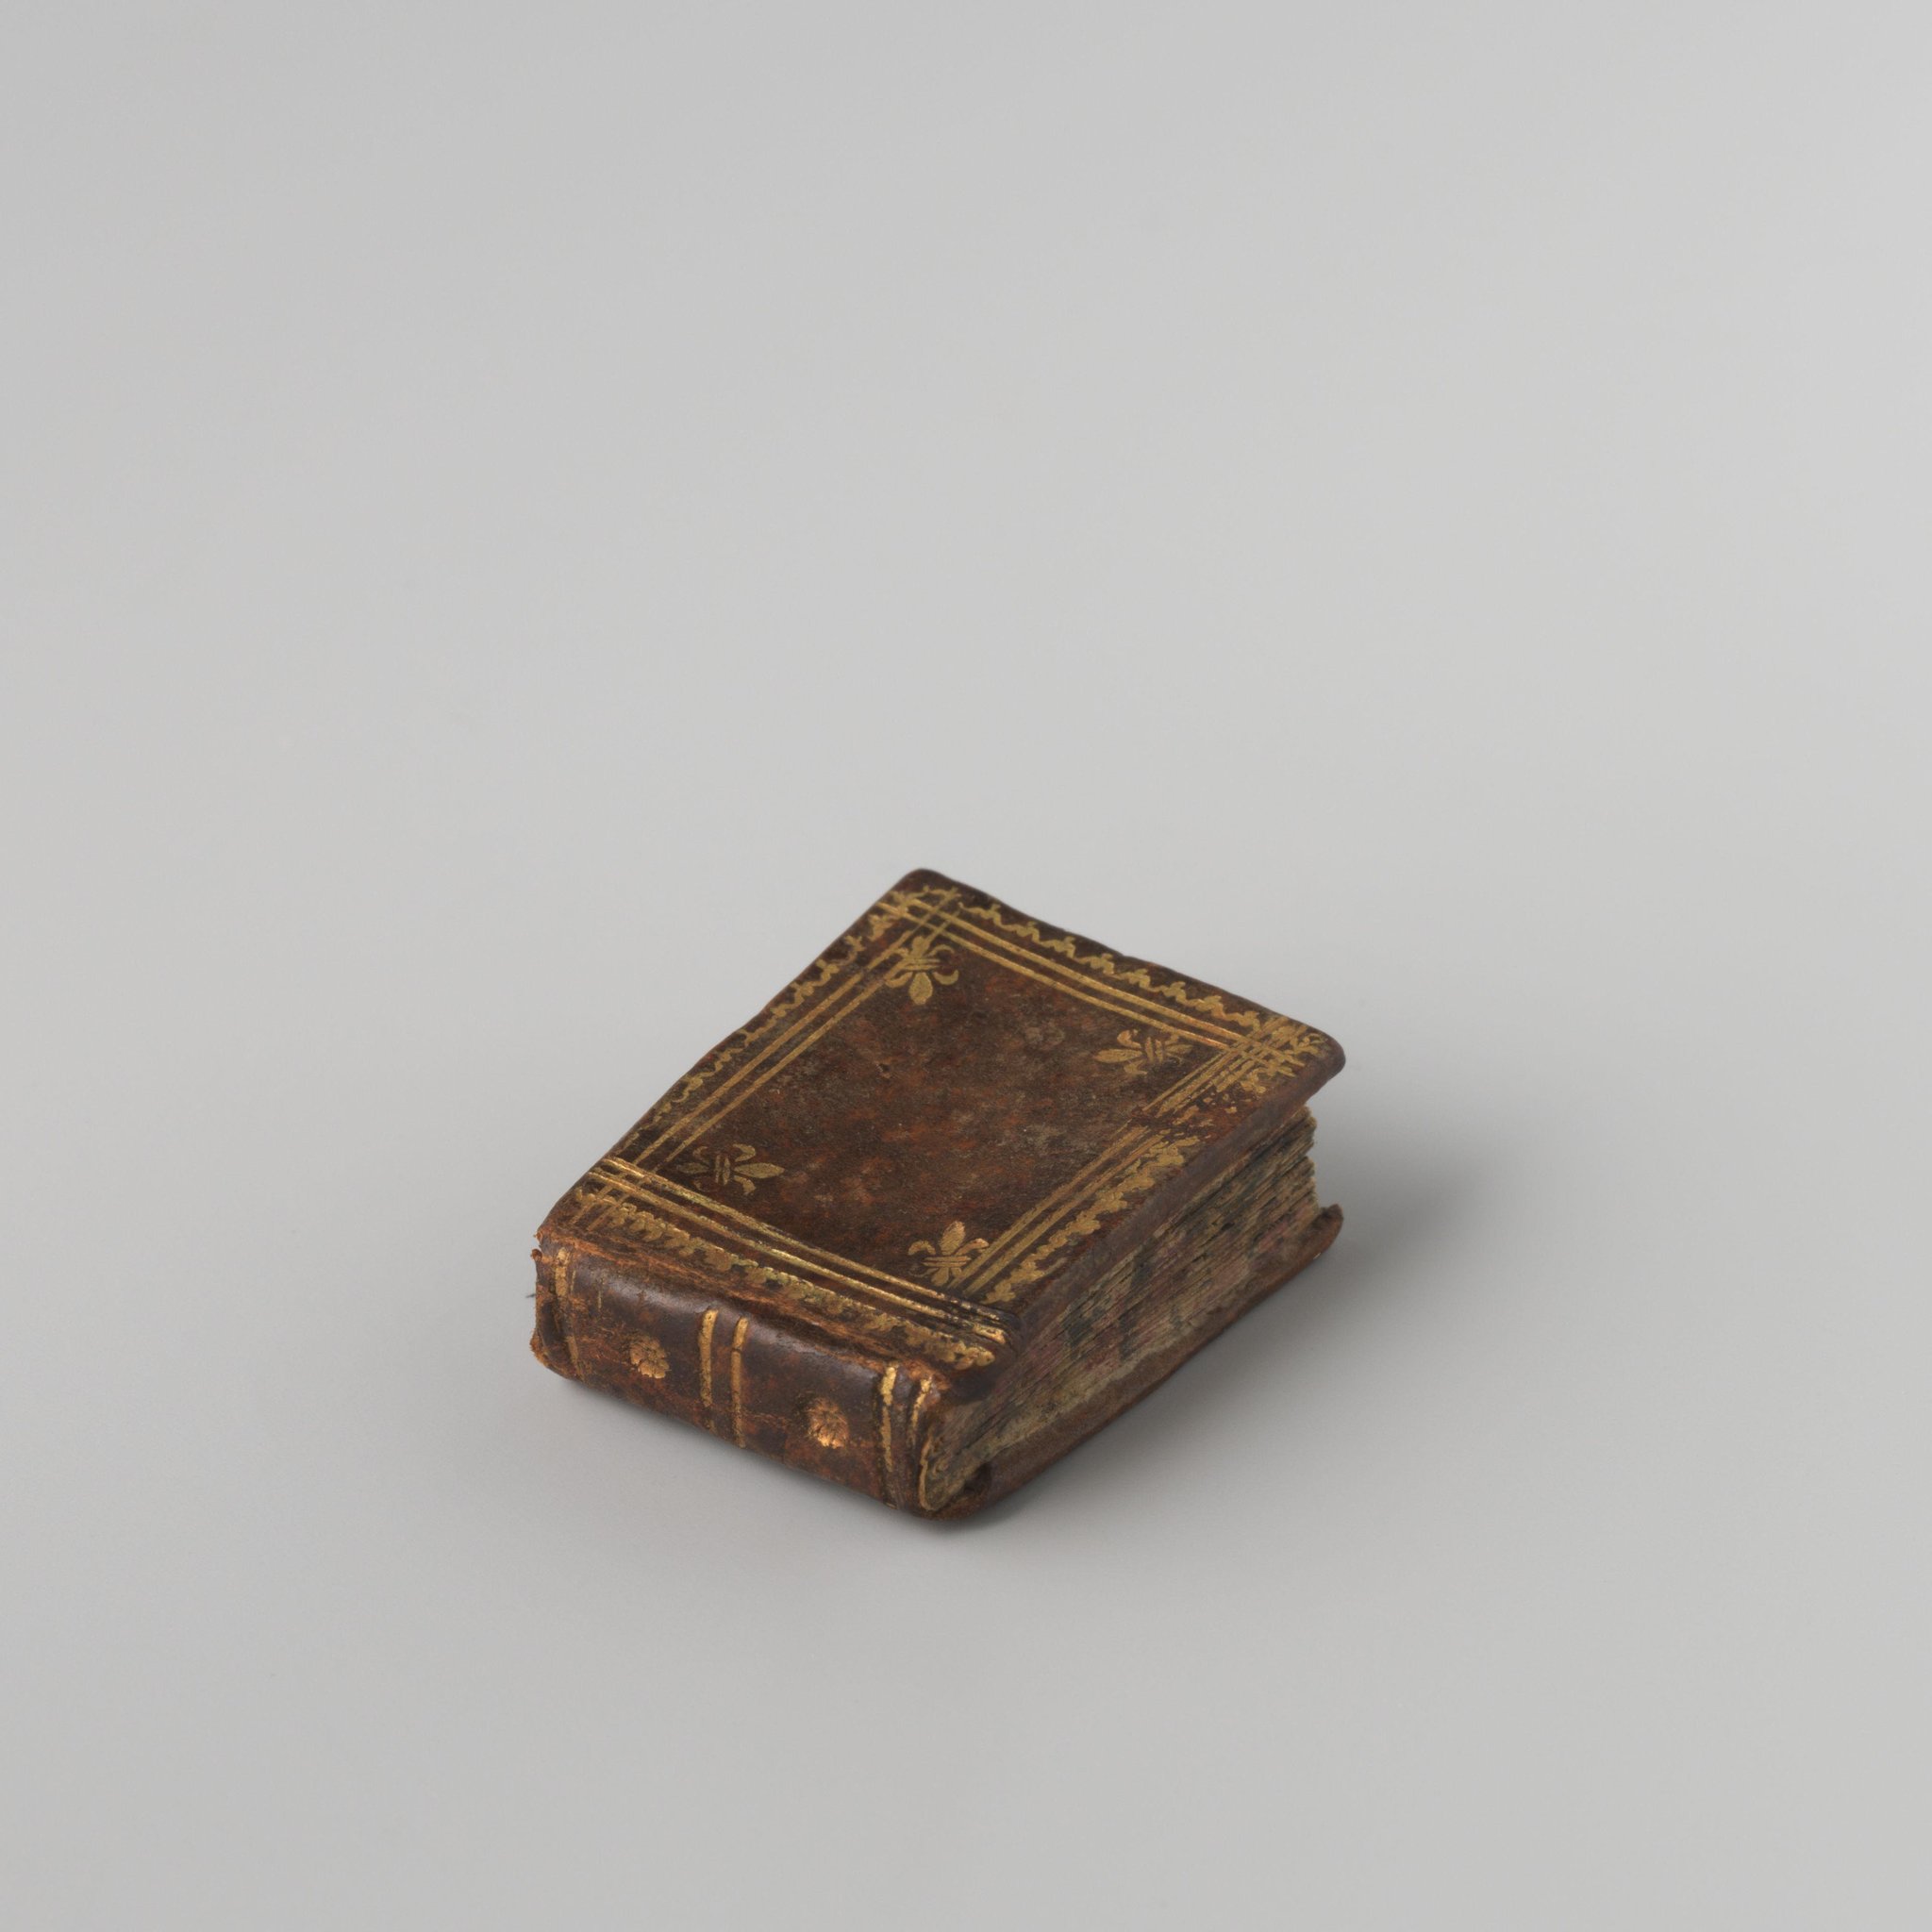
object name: miniature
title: Boek met figuren en tuingezichten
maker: Anonymous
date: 1690-1710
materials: gold, leather, paper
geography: amsterdam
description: Boek met figuren en tuingezichten. Ingebonden in leer met goudopdruk.